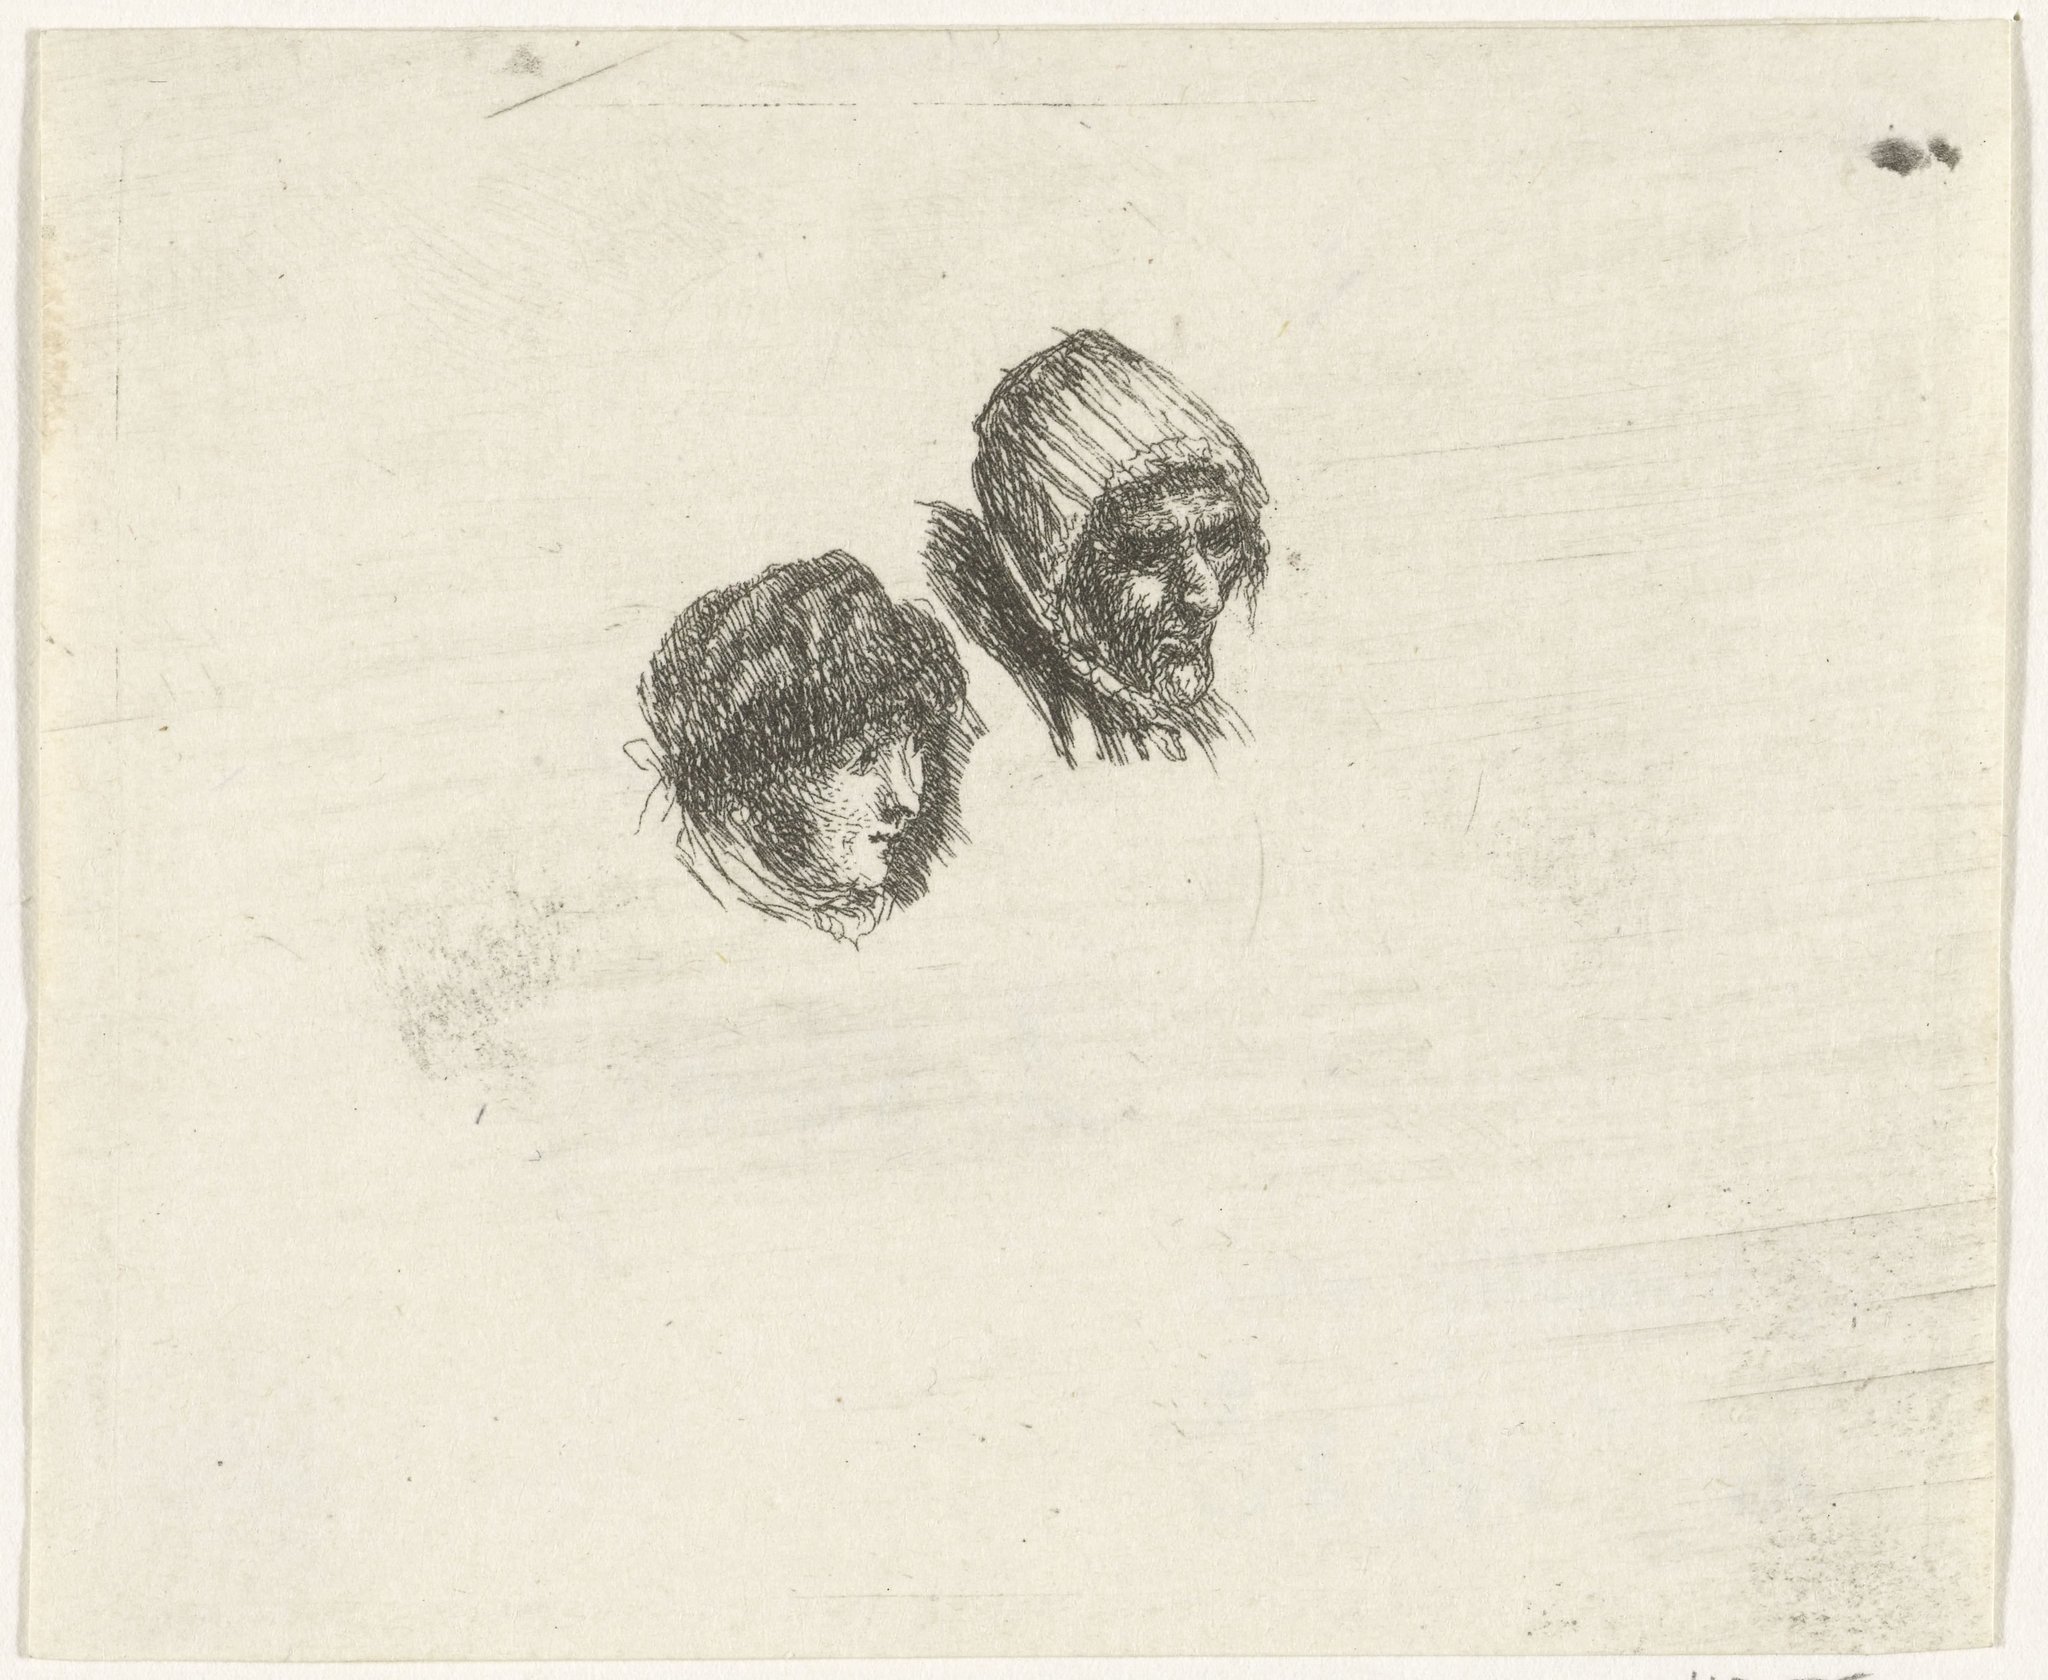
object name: print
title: Studieblad met hoofden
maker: louis bernard coclers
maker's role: draughtsman, print maker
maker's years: 1741-1817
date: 1756-1817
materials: paper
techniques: etching